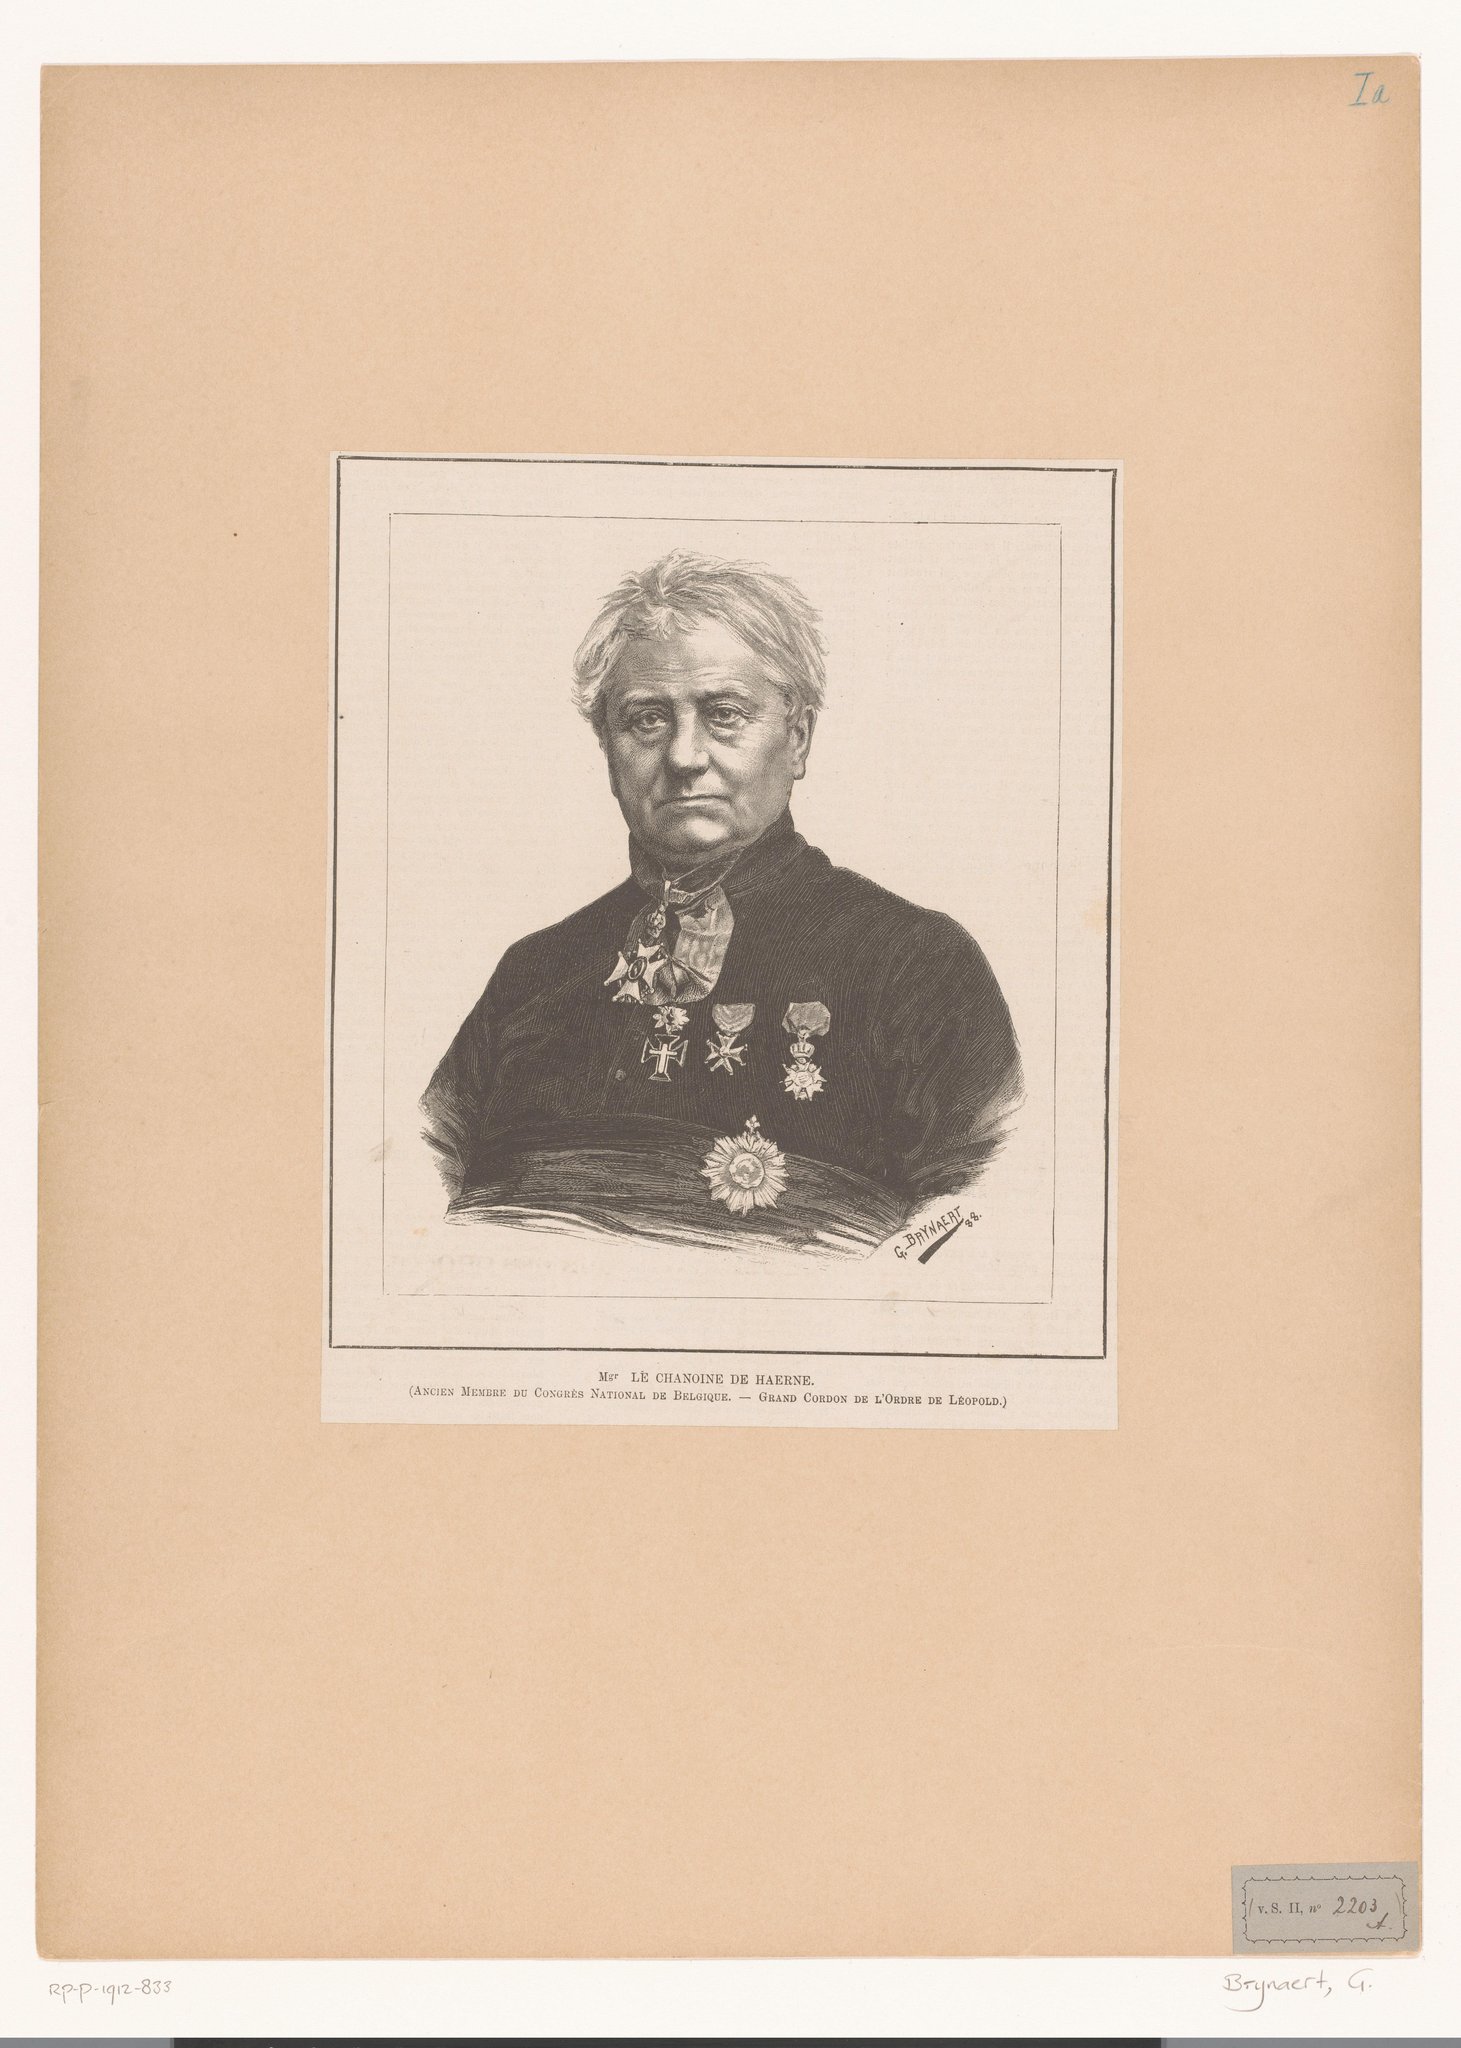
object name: book illustration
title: Portret van Désiré de Haerne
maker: g. brynaert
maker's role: print maker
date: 1888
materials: paper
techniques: letterpress printing, engraving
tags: politician, adult man, historical persons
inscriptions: label: ‘v.S. II, no 2203 A’, collector's mark: Lugt 2228